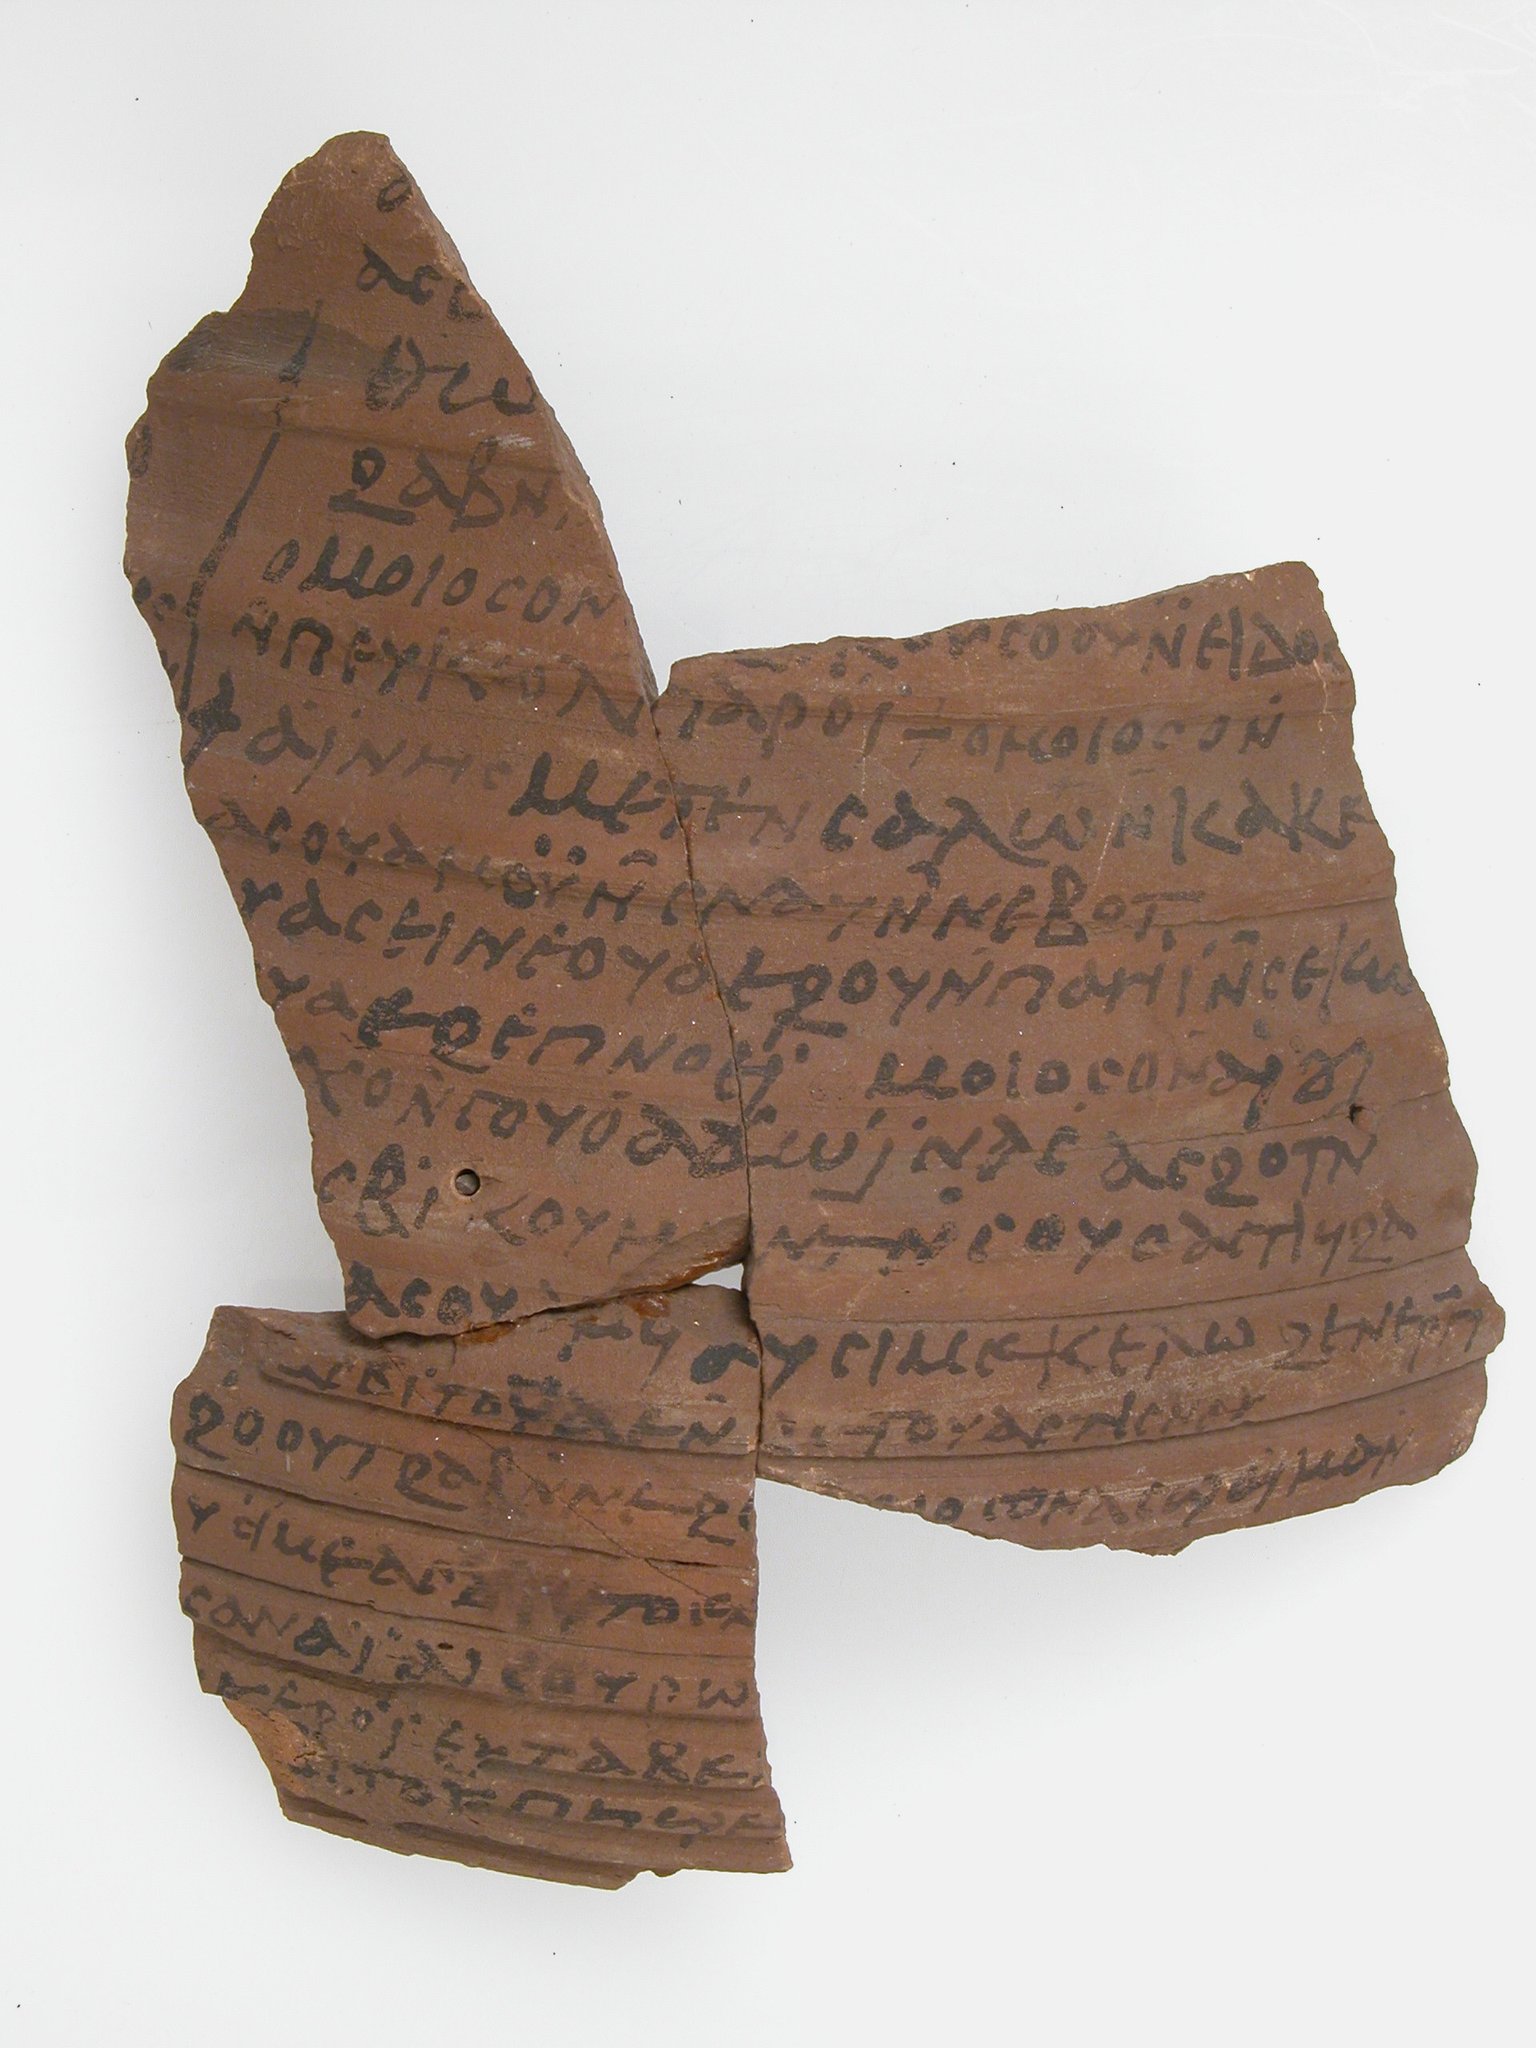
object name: ostrakon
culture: coptic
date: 600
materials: ink, pottery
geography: egypt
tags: coptic,documents